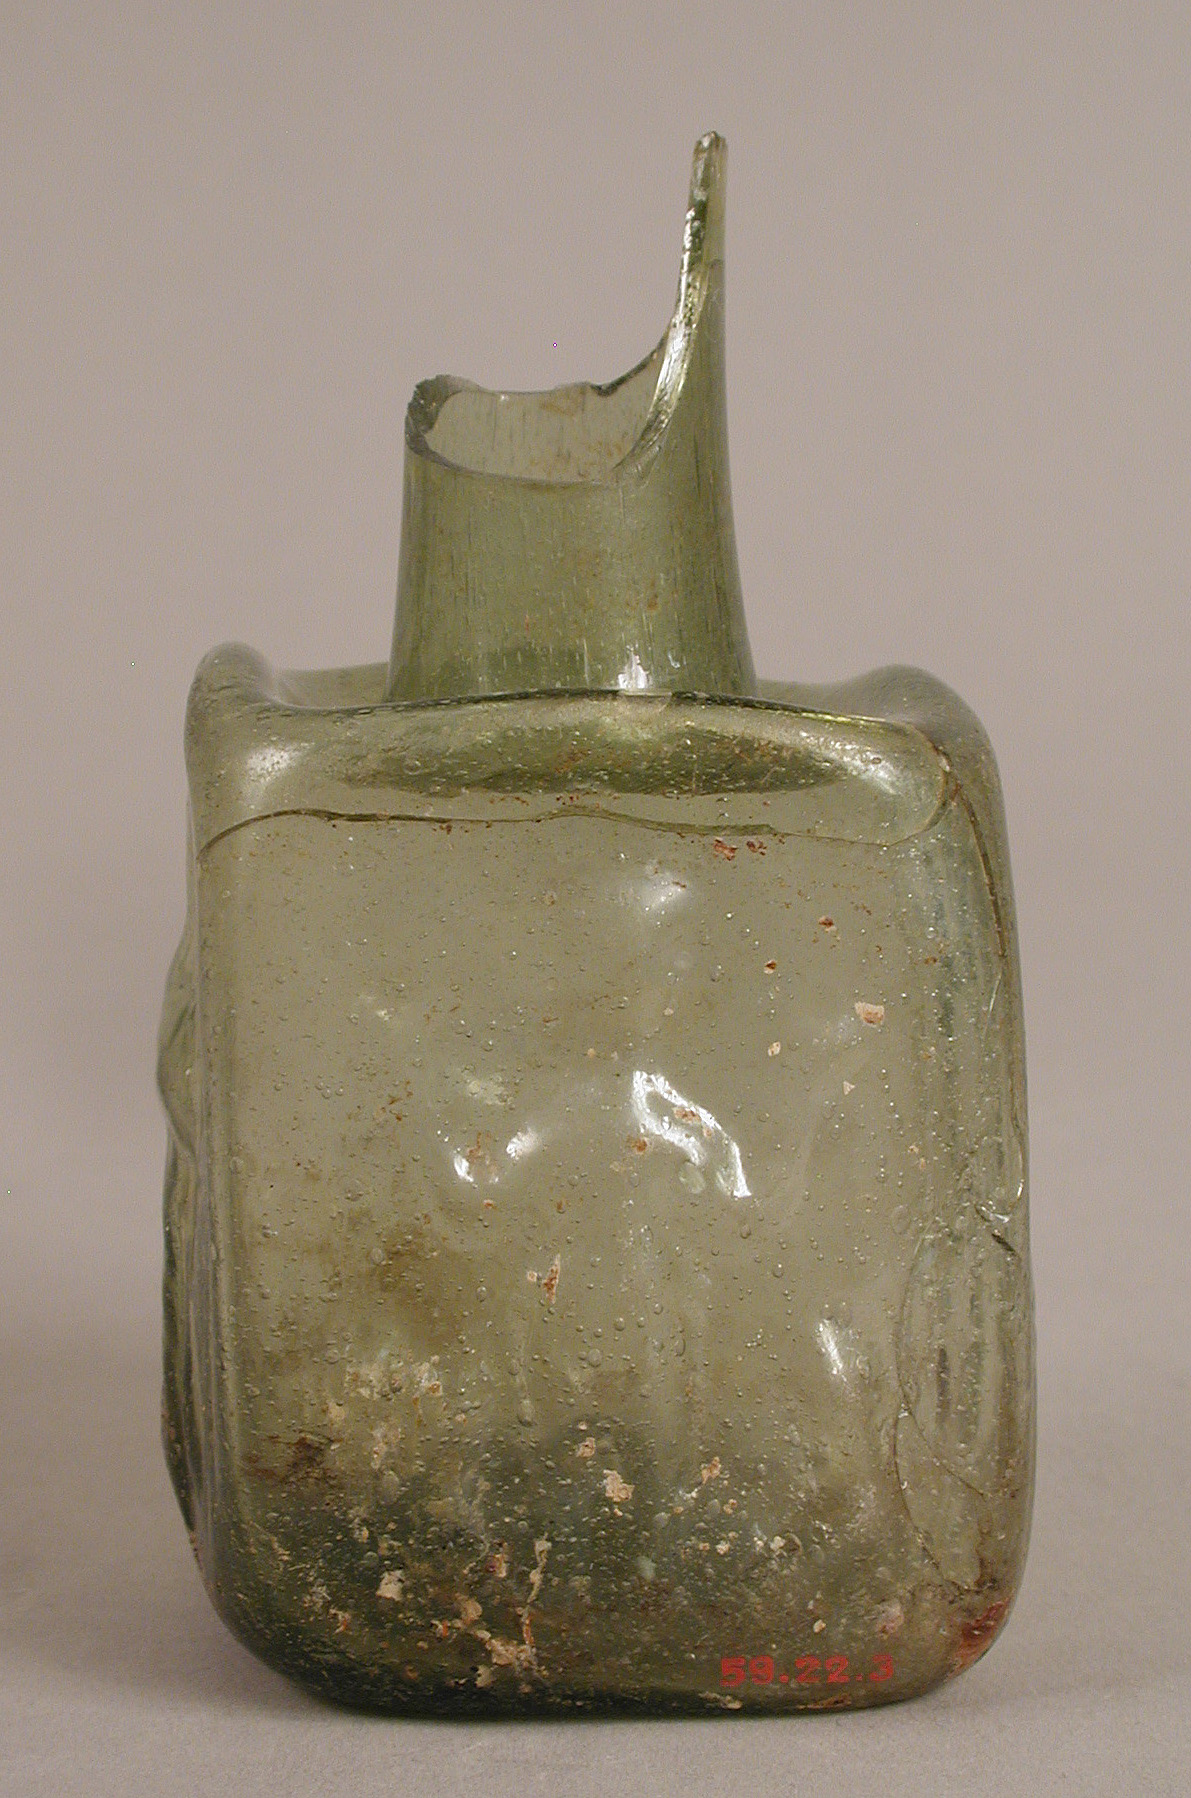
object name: bottle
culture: byzantine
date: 401-500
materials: glass